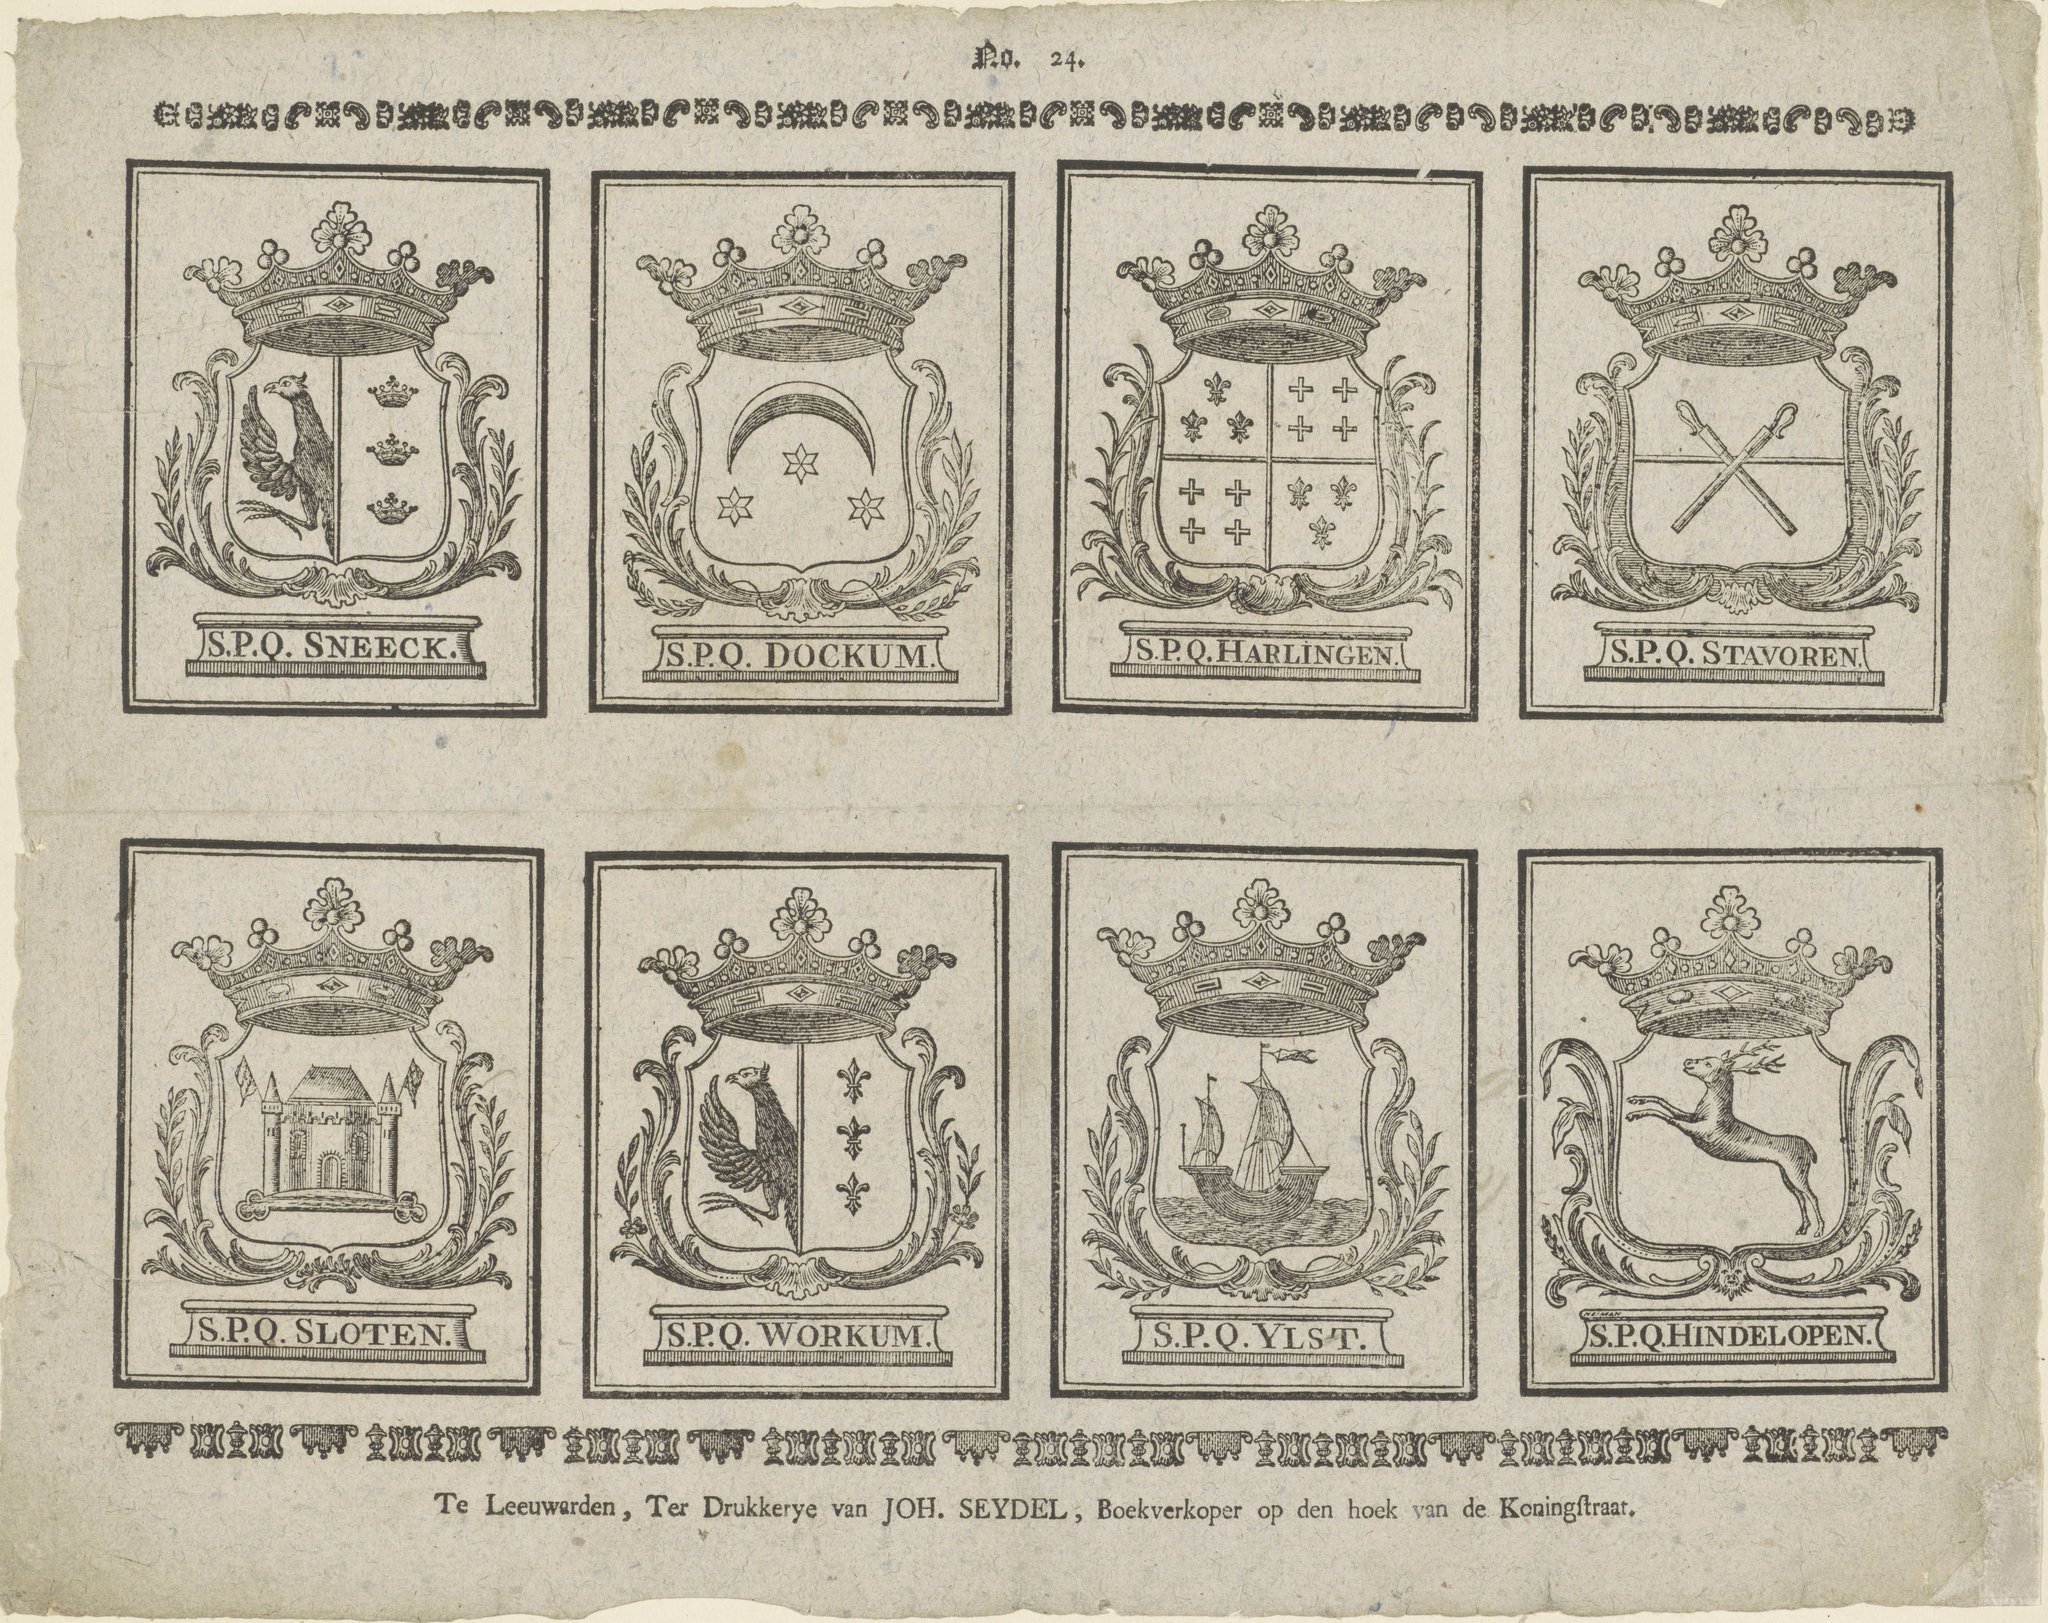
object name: print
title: Wapenschilden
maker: johannes seydel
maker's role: bookseller, publisher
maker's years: -1813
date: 1776-1813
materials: paper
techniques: letterpress printing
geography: leeuwarden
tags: coat of arms (symbol of sovereignty), harlingen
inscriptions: collector's mark: Lugt 2760, inscription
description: Blad met 8 voorstellingen van de wapenschilden van Sneek, Dokkum, Harlingen, Stavoren, Sloten, Workum, IJlst en Hindeloopen. Genummerd midden boven: No. 24.